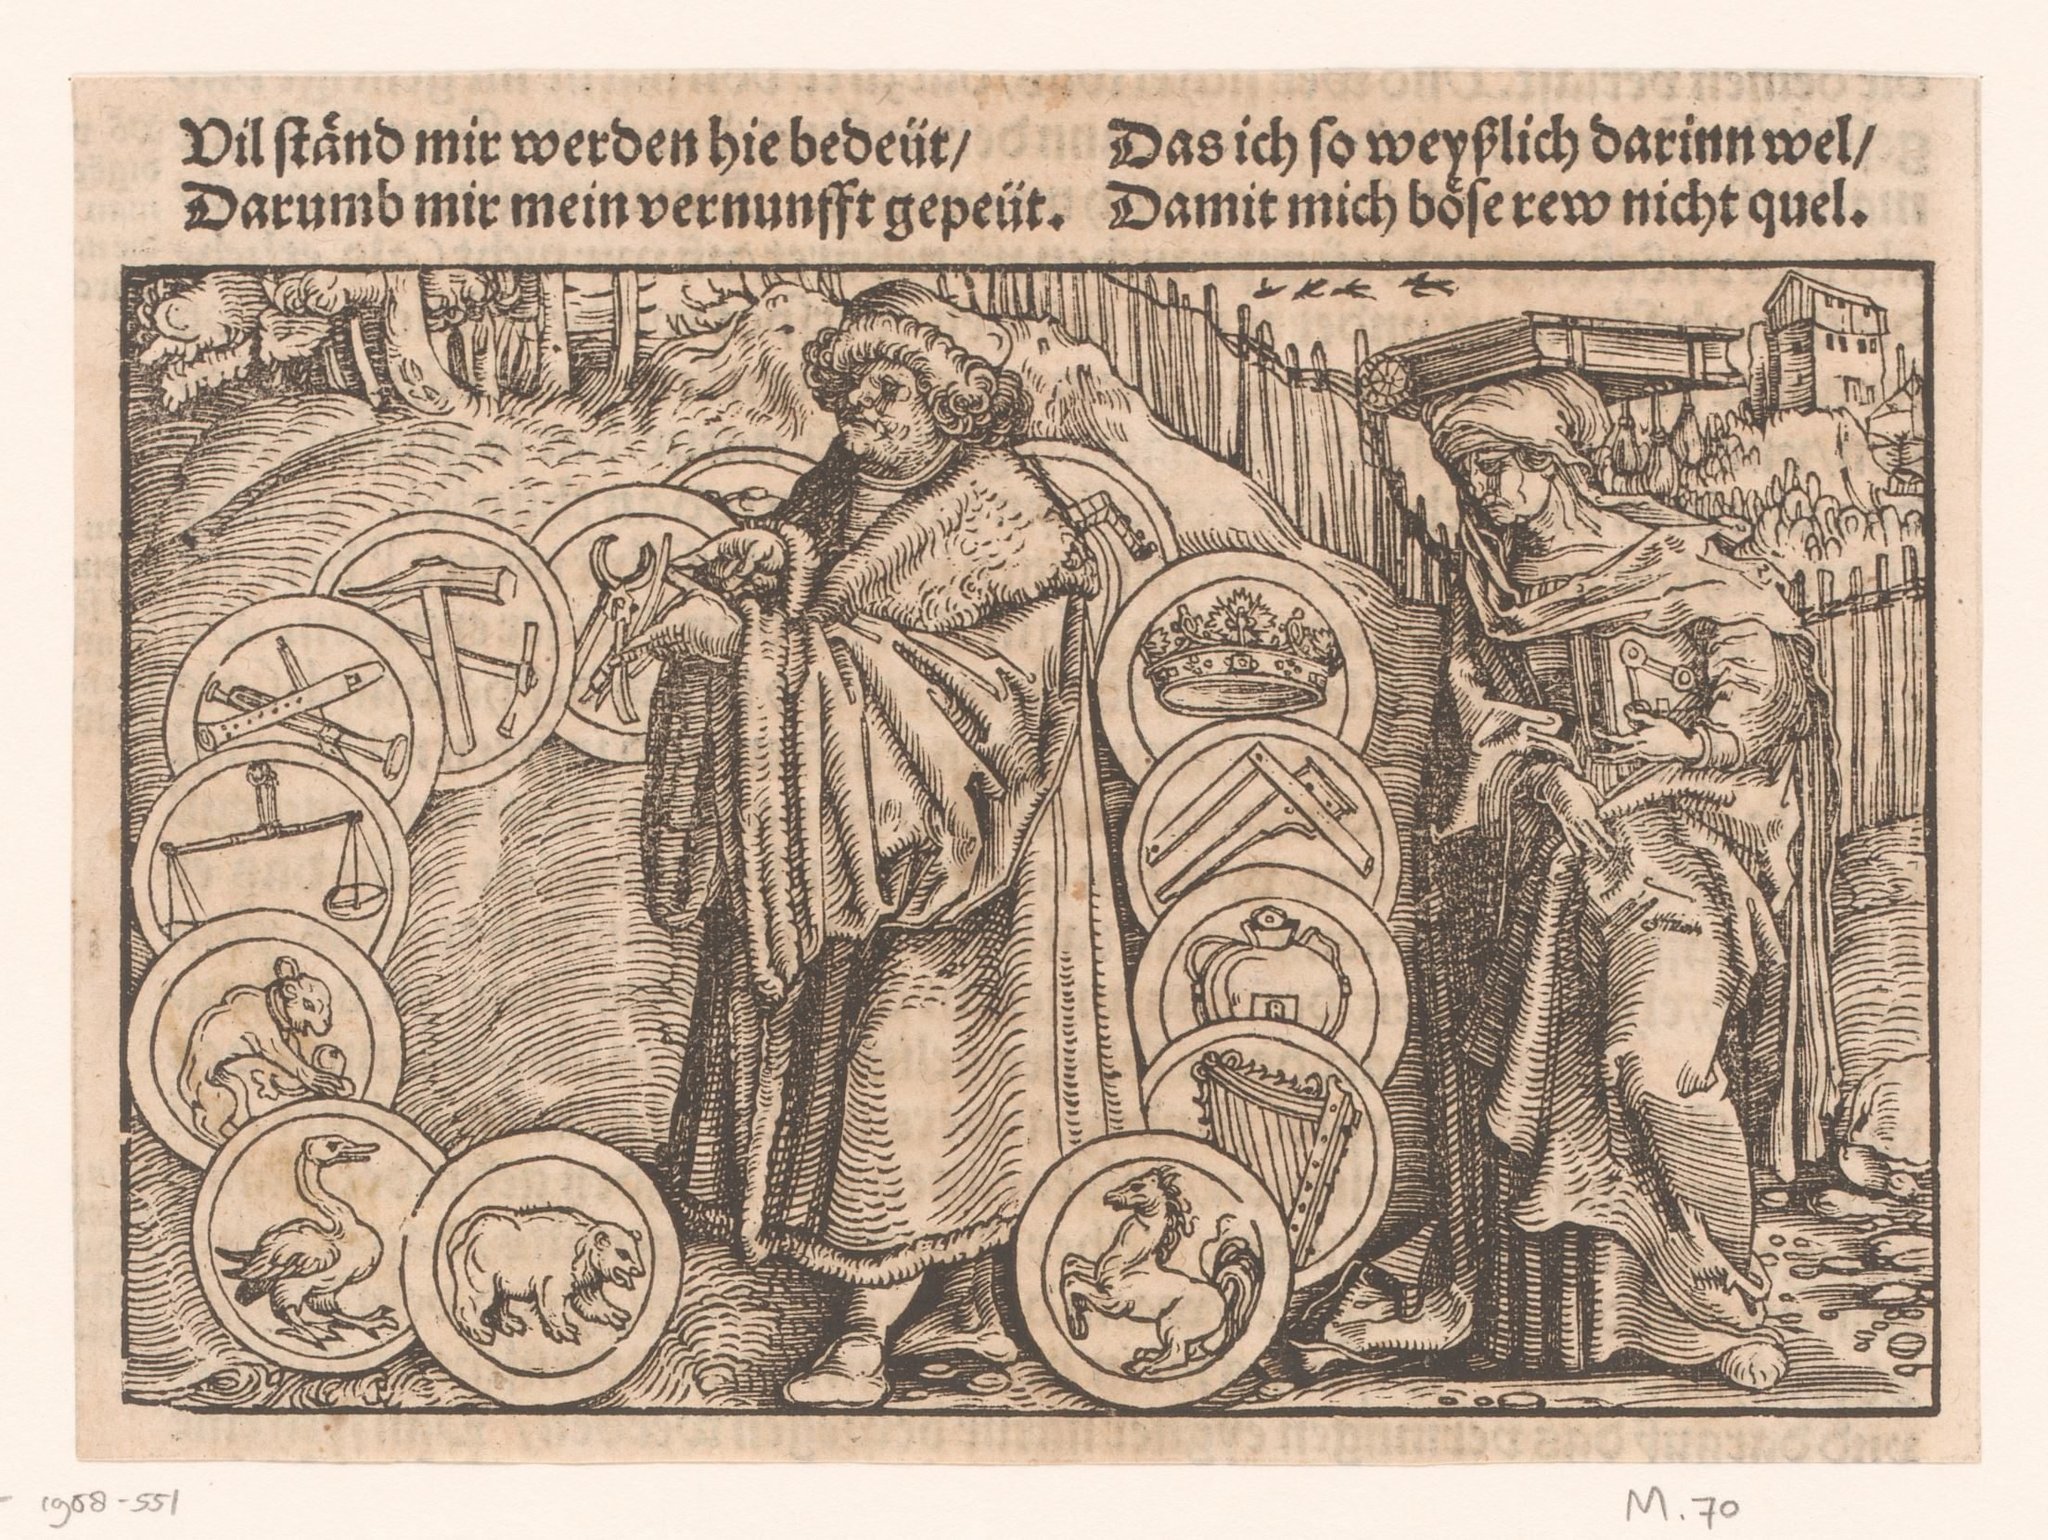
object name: print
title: Staande geleerde omringd door symbolen, naast hem een allegorische vrouwenfiguur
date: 1532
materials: paper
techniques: woodcut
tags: wisdom; 'sapienza', 'sapienza humana', 'sapienza vera' (ripa), scholar, philosopher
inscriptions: collector's mark: Lugt 2228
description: Prent voor het eerst gebruikt in: Petrarca, Francesco. Von der Artzney bayder Glück. Augsburg: Heinrich Steiner, 1532.